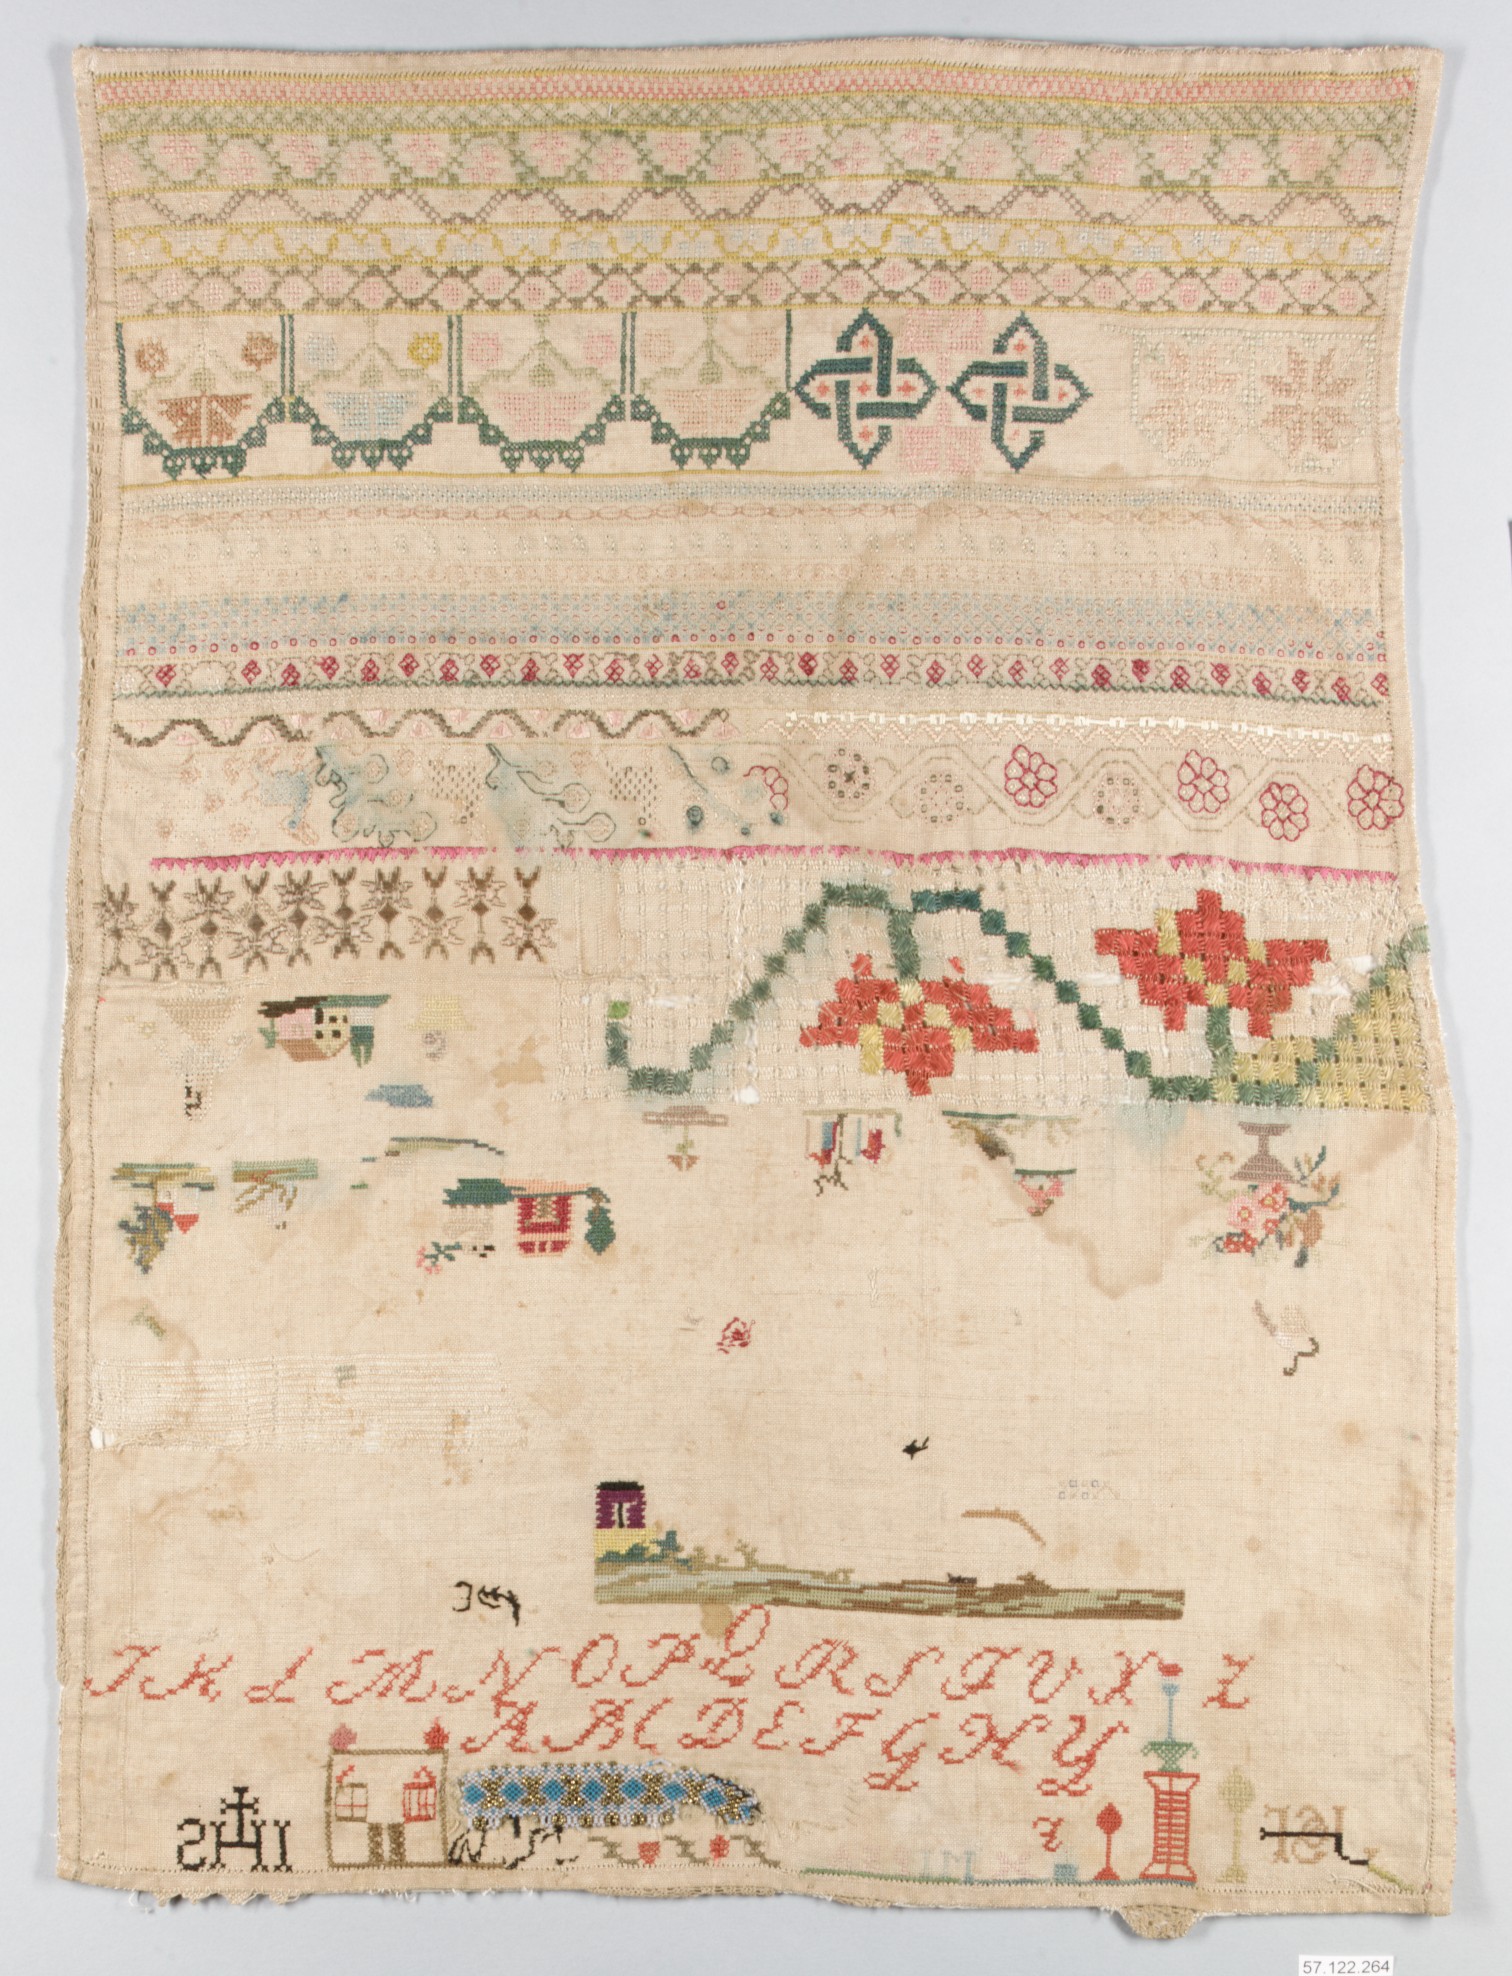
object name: sampler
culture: mexican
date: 1801-1900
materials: linen, silk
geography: mexico